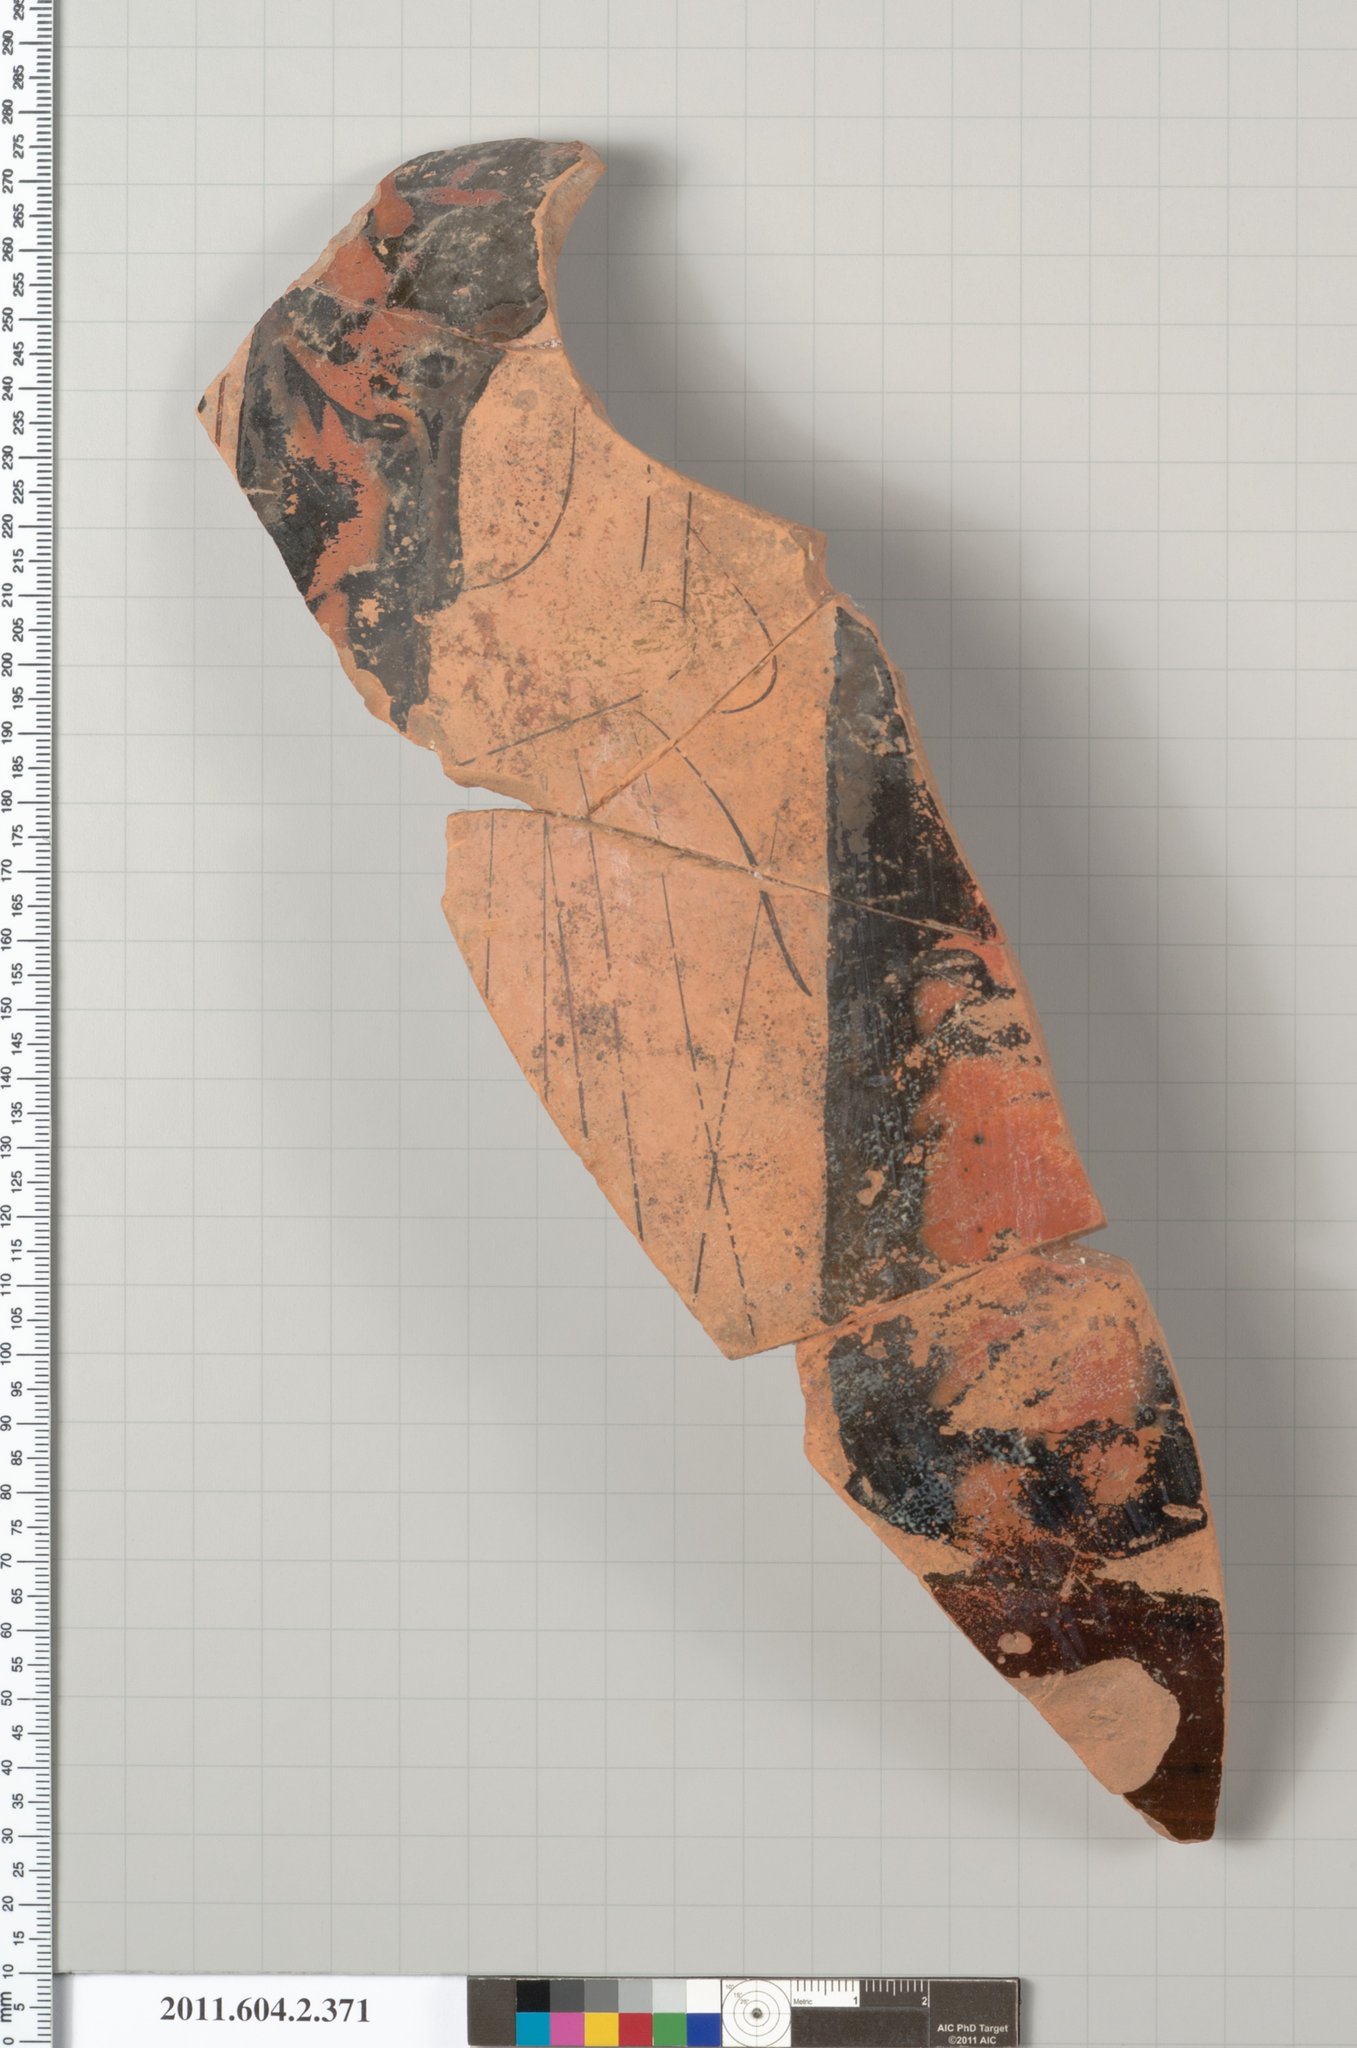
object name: column krater fragment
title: Terracotta fragment of a column-krater (bowl for mixing wine and water)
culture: greek, attic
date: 450-430 BCE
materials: terracotta